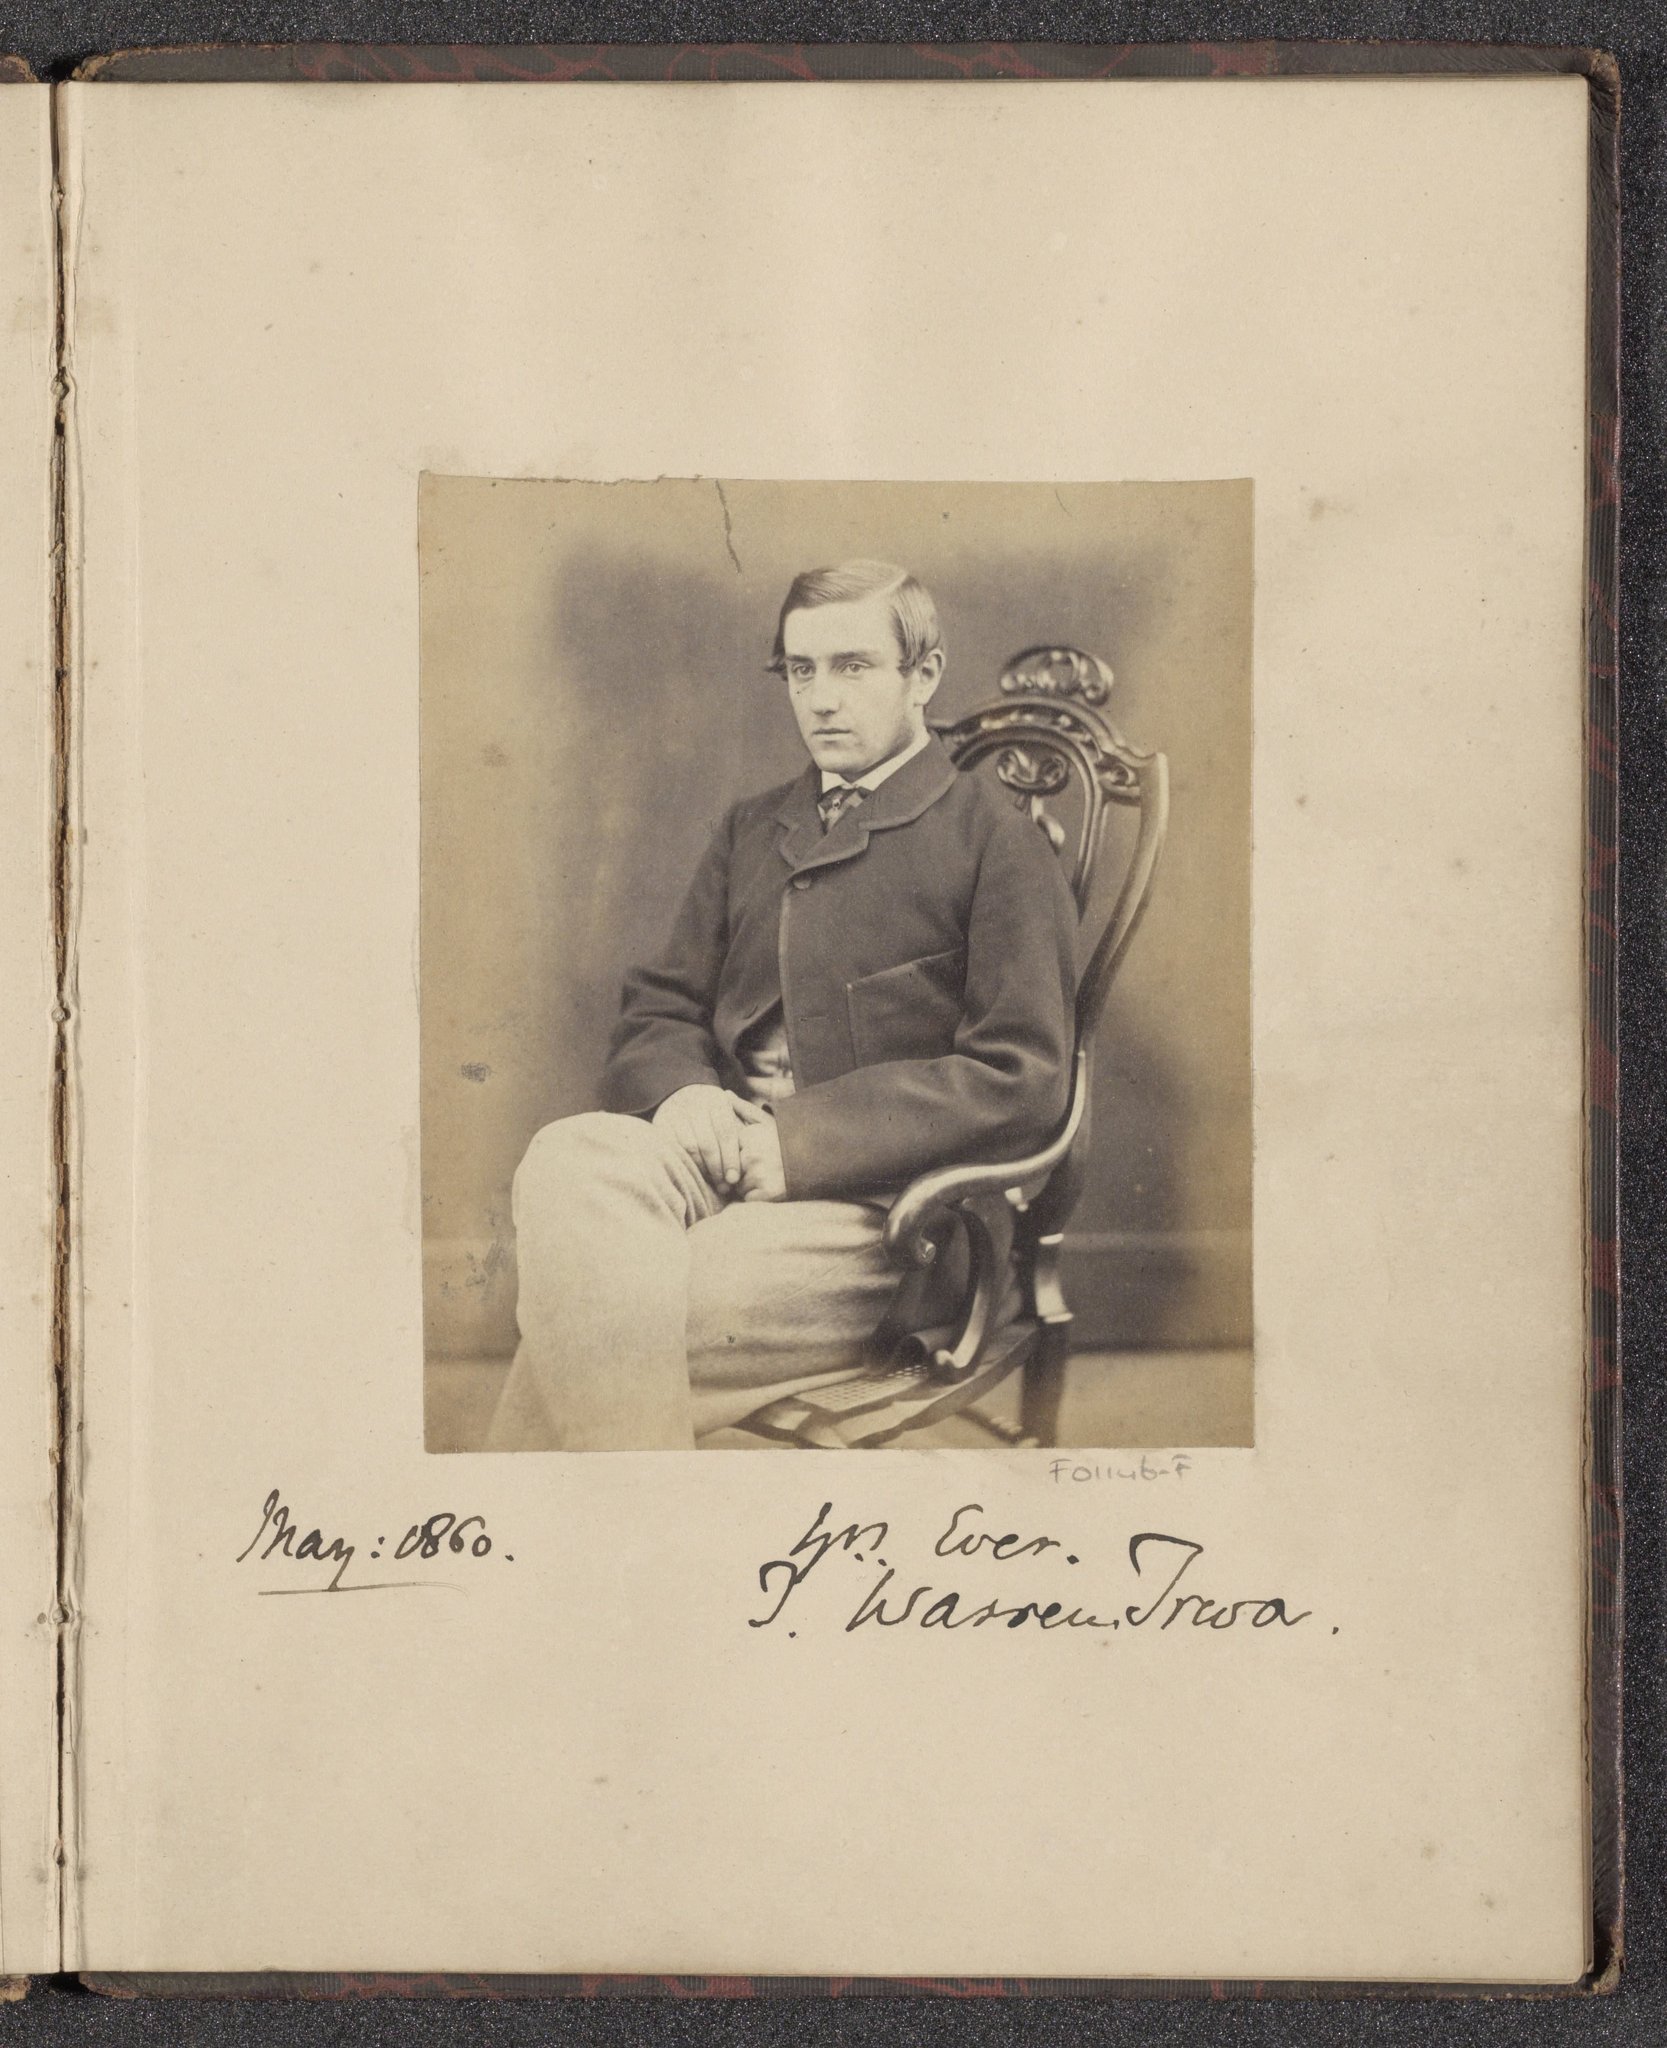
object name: photograph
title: Portret van J. Warren Treva, student in Oxford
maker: j. bagnall evans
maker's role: fotograaf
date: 1805-1860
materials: paper, photographic support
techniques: albumen print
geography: oxford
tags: armchair, seat, trousers, breeches, higher education, e.g.: teacher's college (+ pupil), university education, youth, adolescent, student, coat, cape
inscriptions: inscription: ‘May: 1860. Yrs ever, J. Warren Treva.’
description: Onderdeel van Fotoalbum met 6 portretten van studenten van het Jesus College in Oxford.